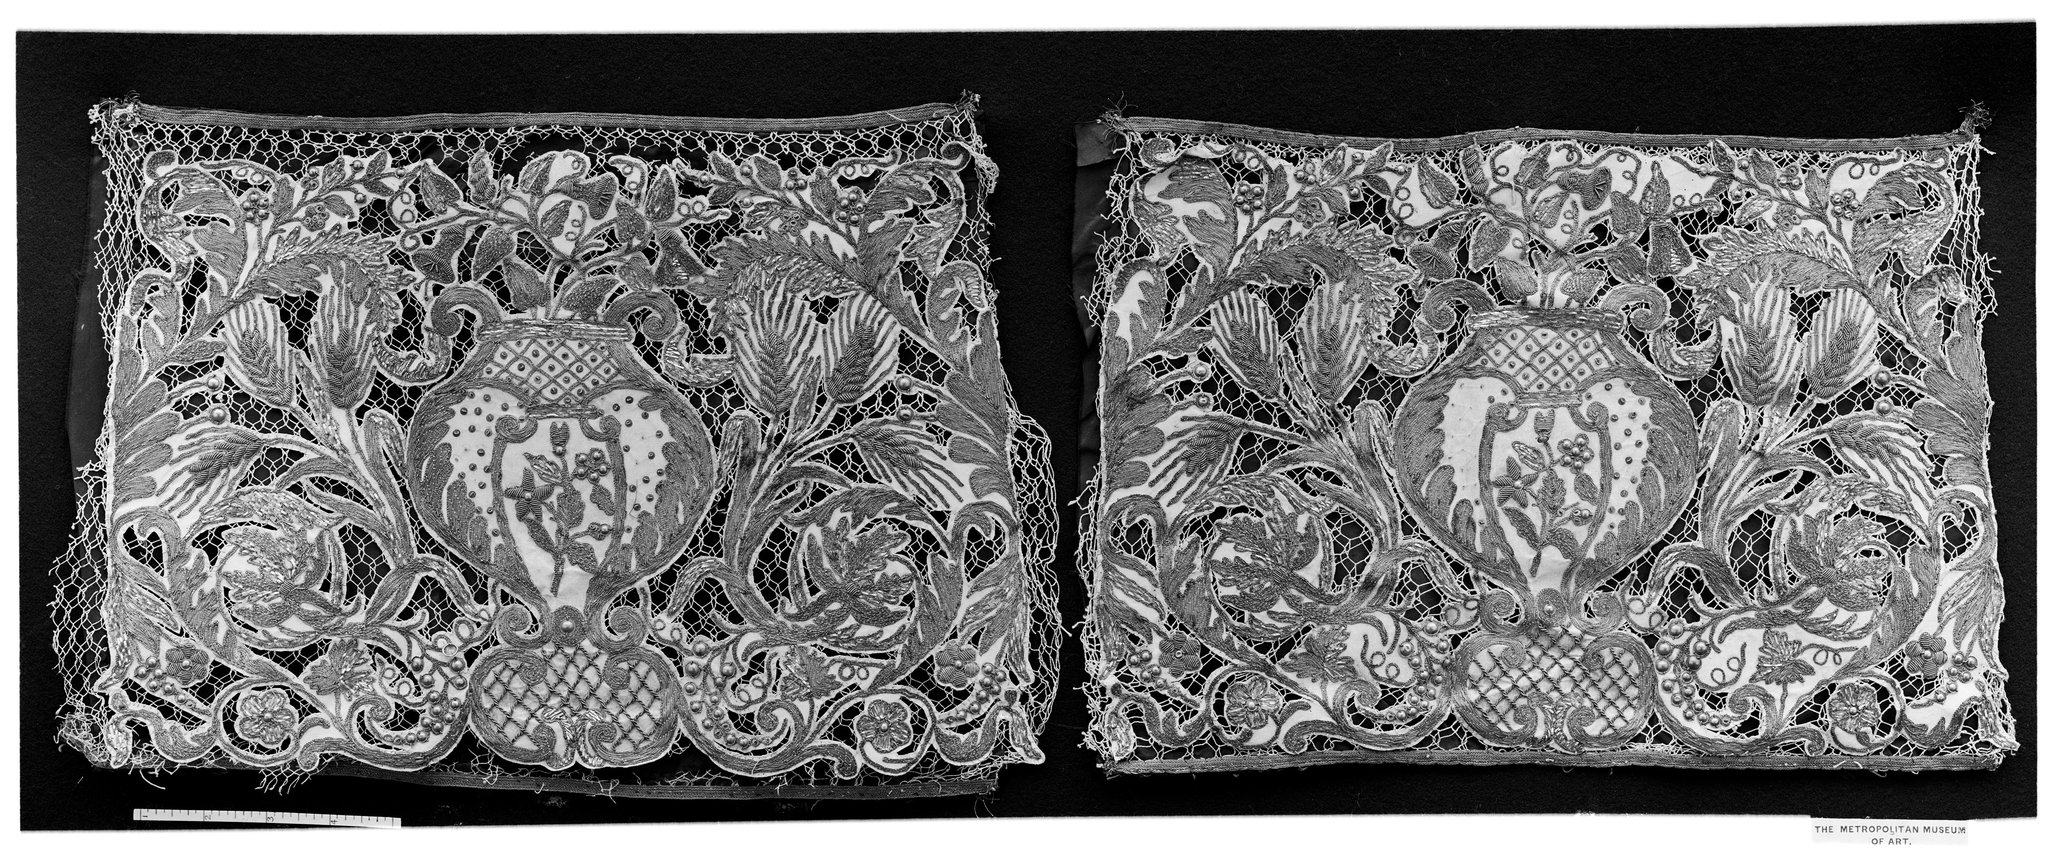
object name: cuff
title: Pair of cuffs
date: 1701-1800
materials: metal thread